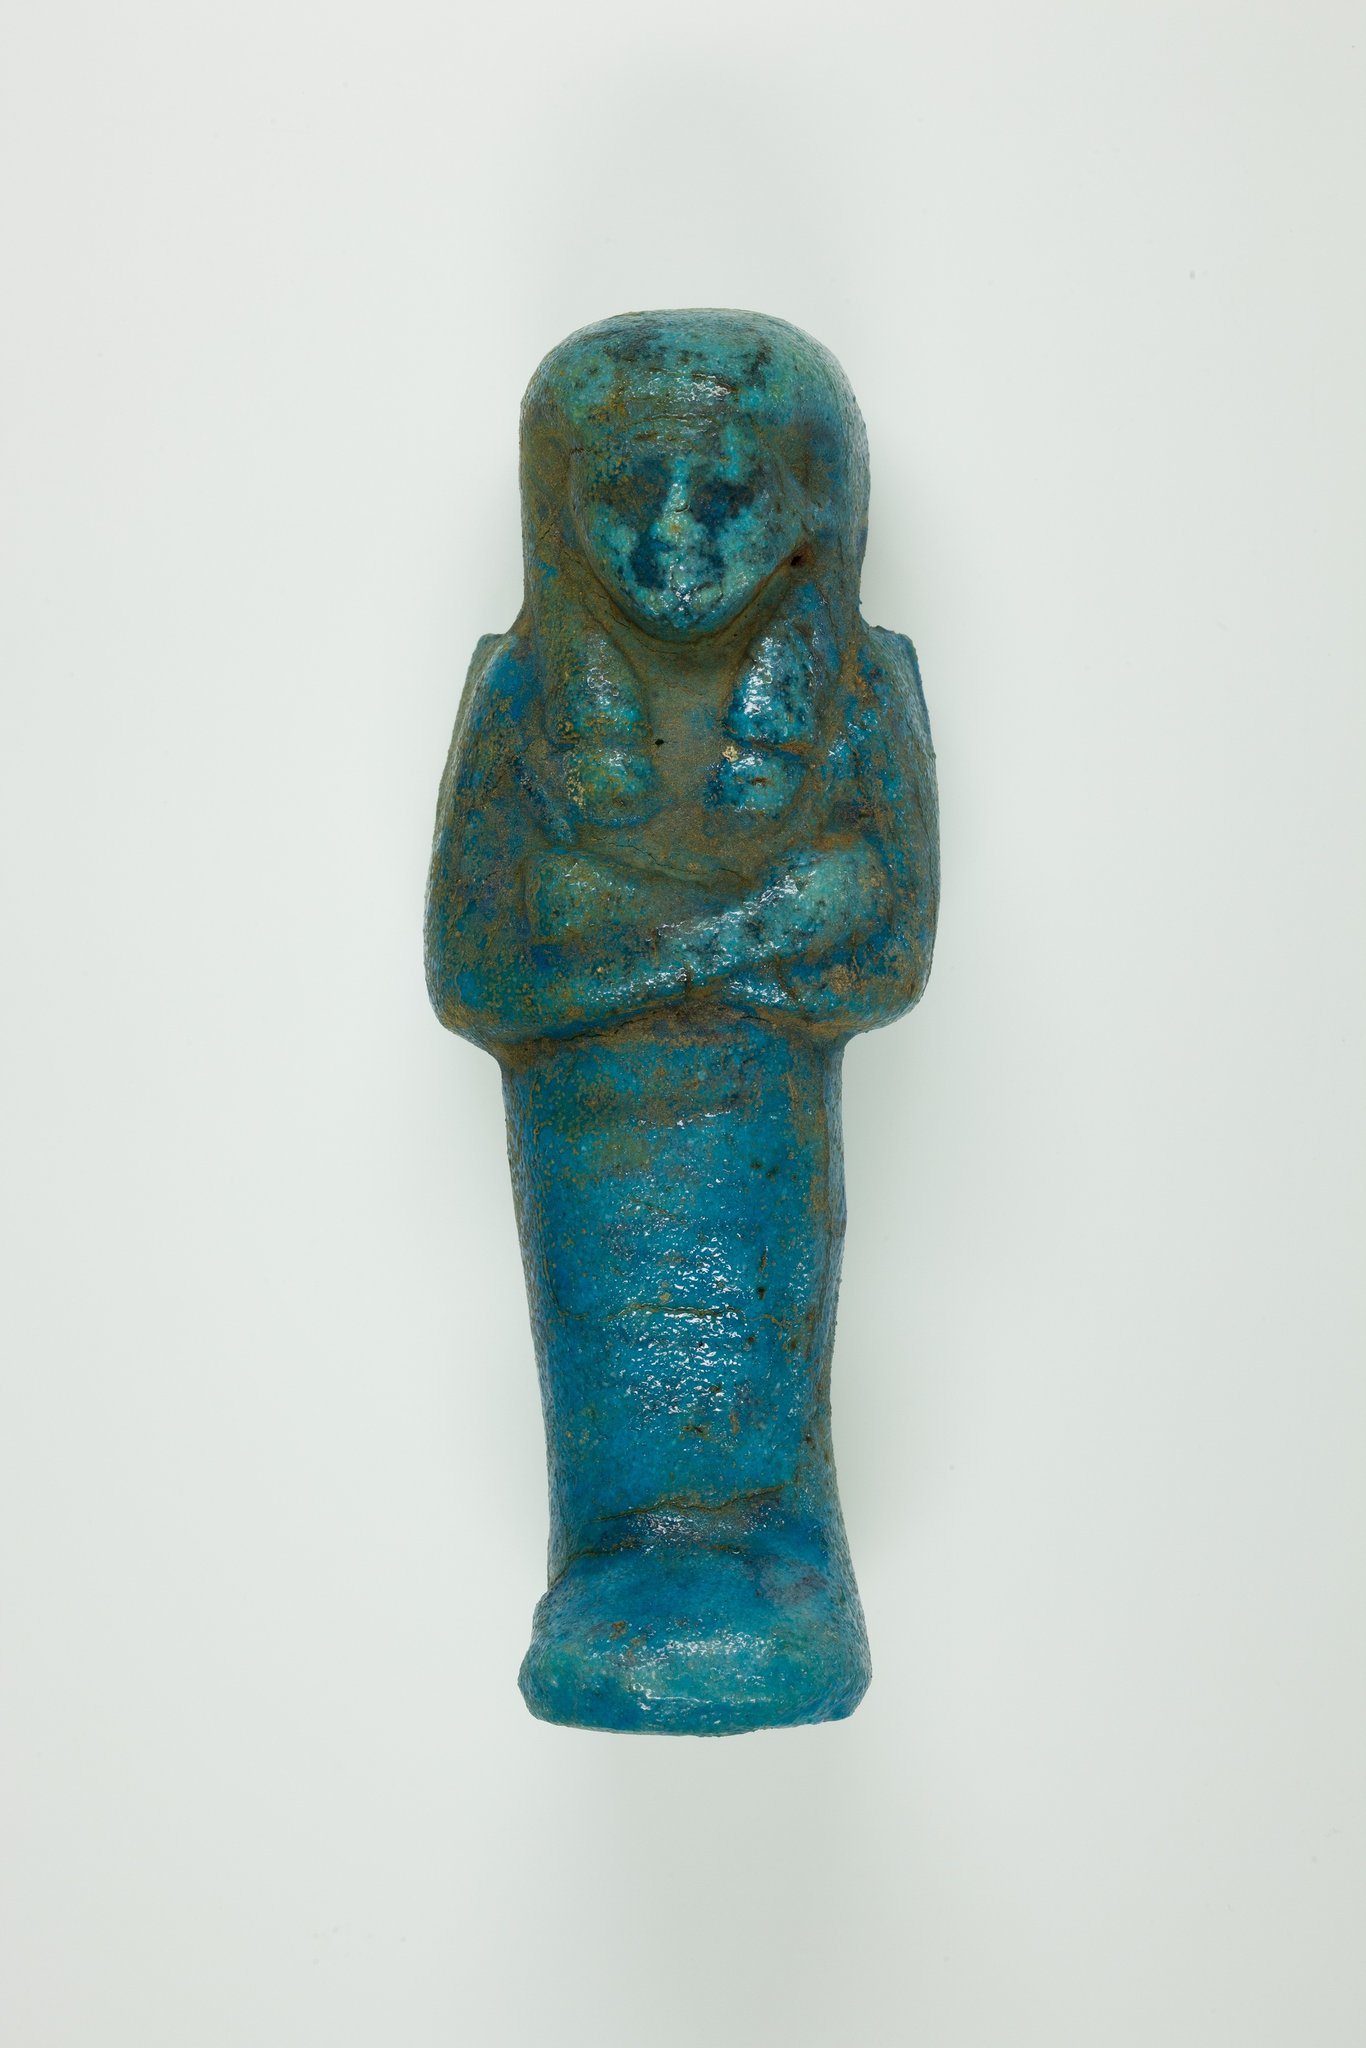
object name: worker shabti, henettawy c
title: Worker Shabti of Henettawy (C), Daughter of Isetemkheb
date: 990-970 BCE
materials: faience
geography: egypt